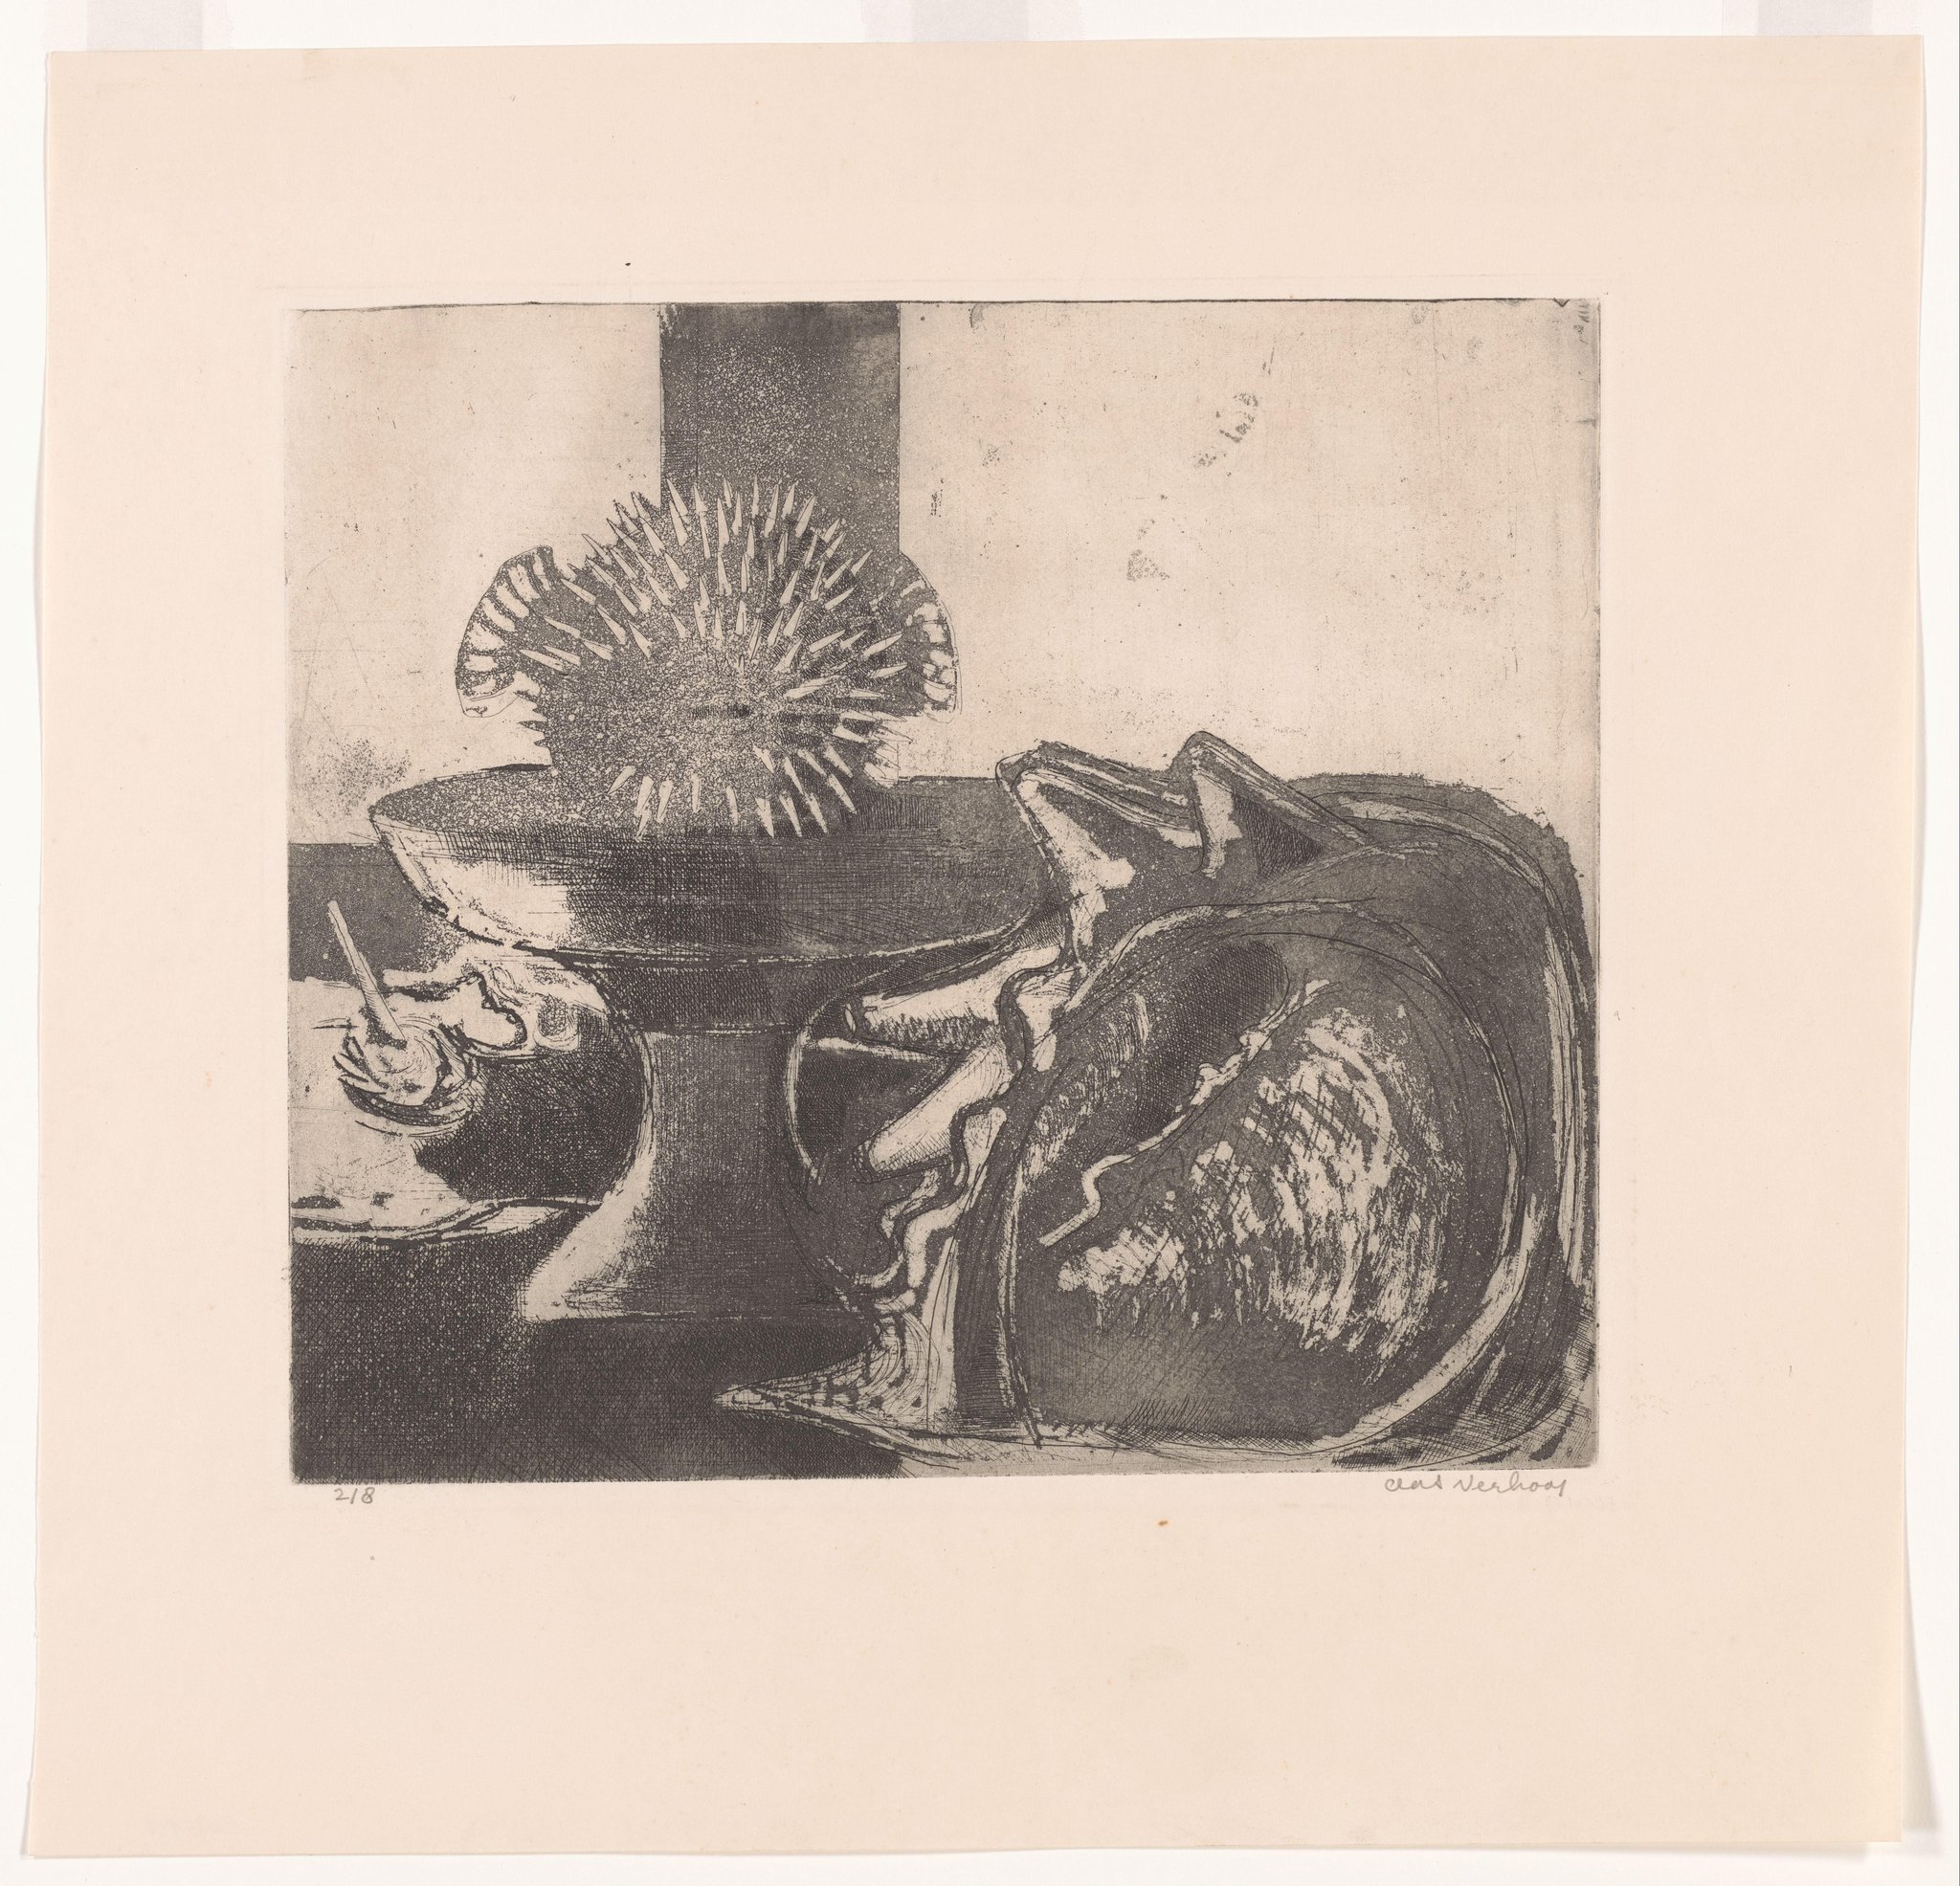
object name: print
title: Koffervis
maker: aat verhoog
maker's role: print maker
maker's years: 1933-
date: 1958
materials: paper, ink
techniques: aquatint, etching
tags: other fishes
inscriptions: signature: ‘Aat Verhoog’, edition: ‘2/8’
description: De huidige titel is door het Rijksmuseum overgenomen van het Instituut Collectie Nederland.